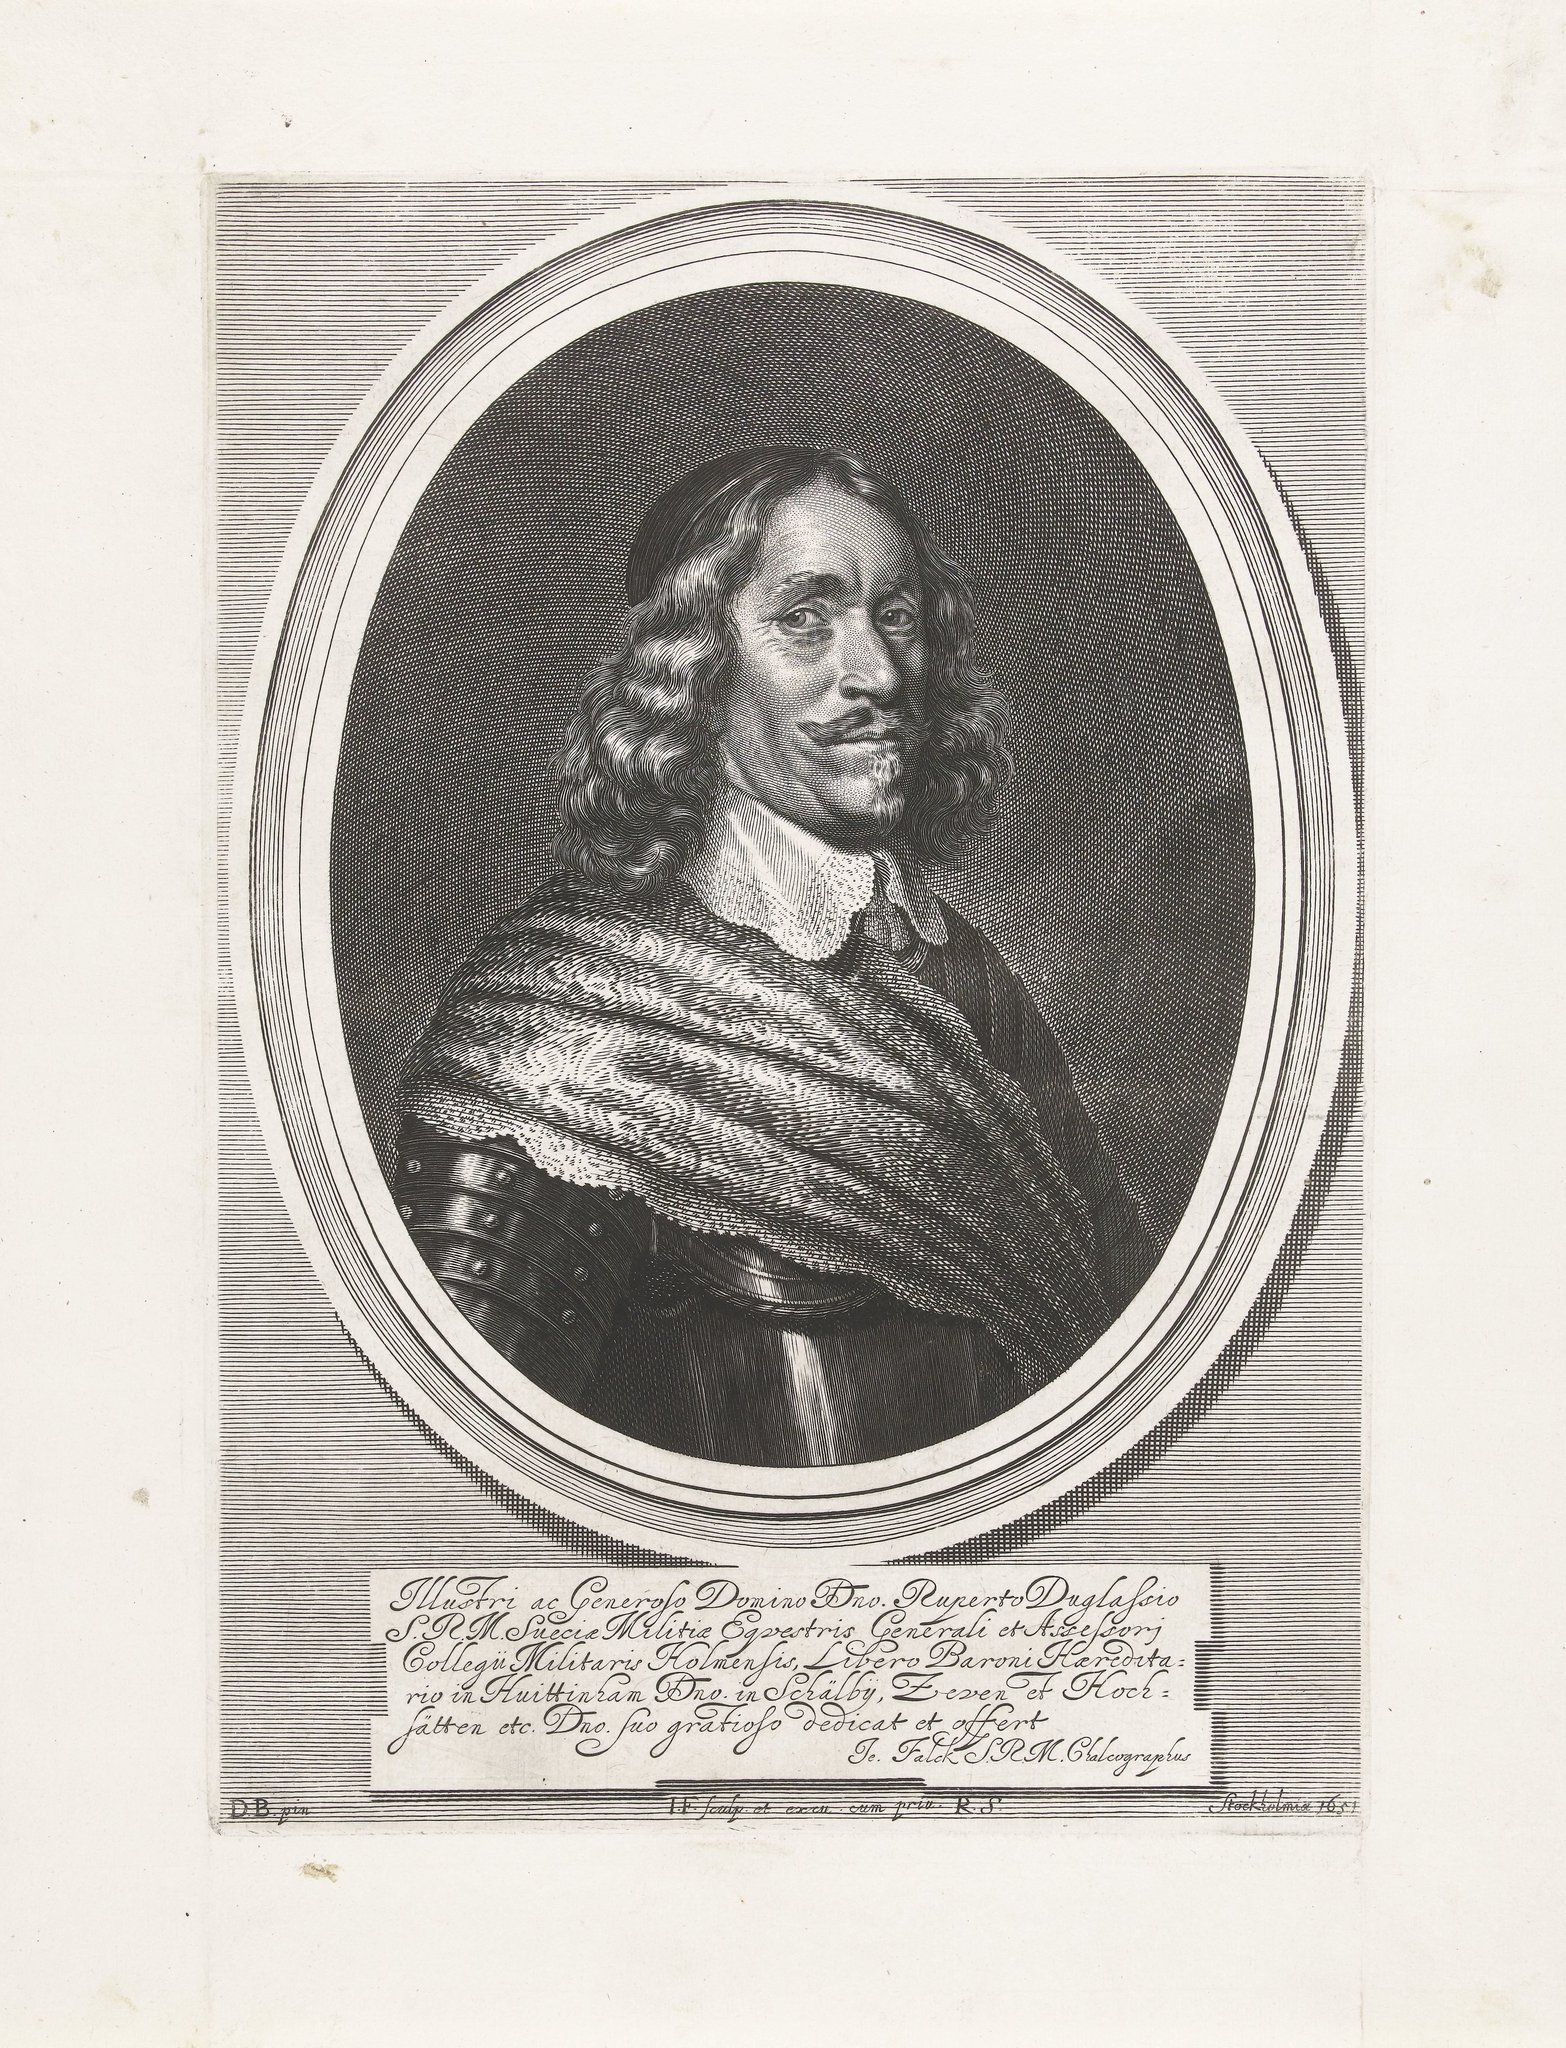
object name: print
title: Portret van Rupert Douglas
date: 1651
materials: paper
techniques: engraving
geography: stockholm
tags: rupert douglas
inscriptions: collector's mark: Lugt 240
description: Portret van de Zweedse generaal Rupert Douglas, in ovale omlijsting met onderschrift in Latijn.